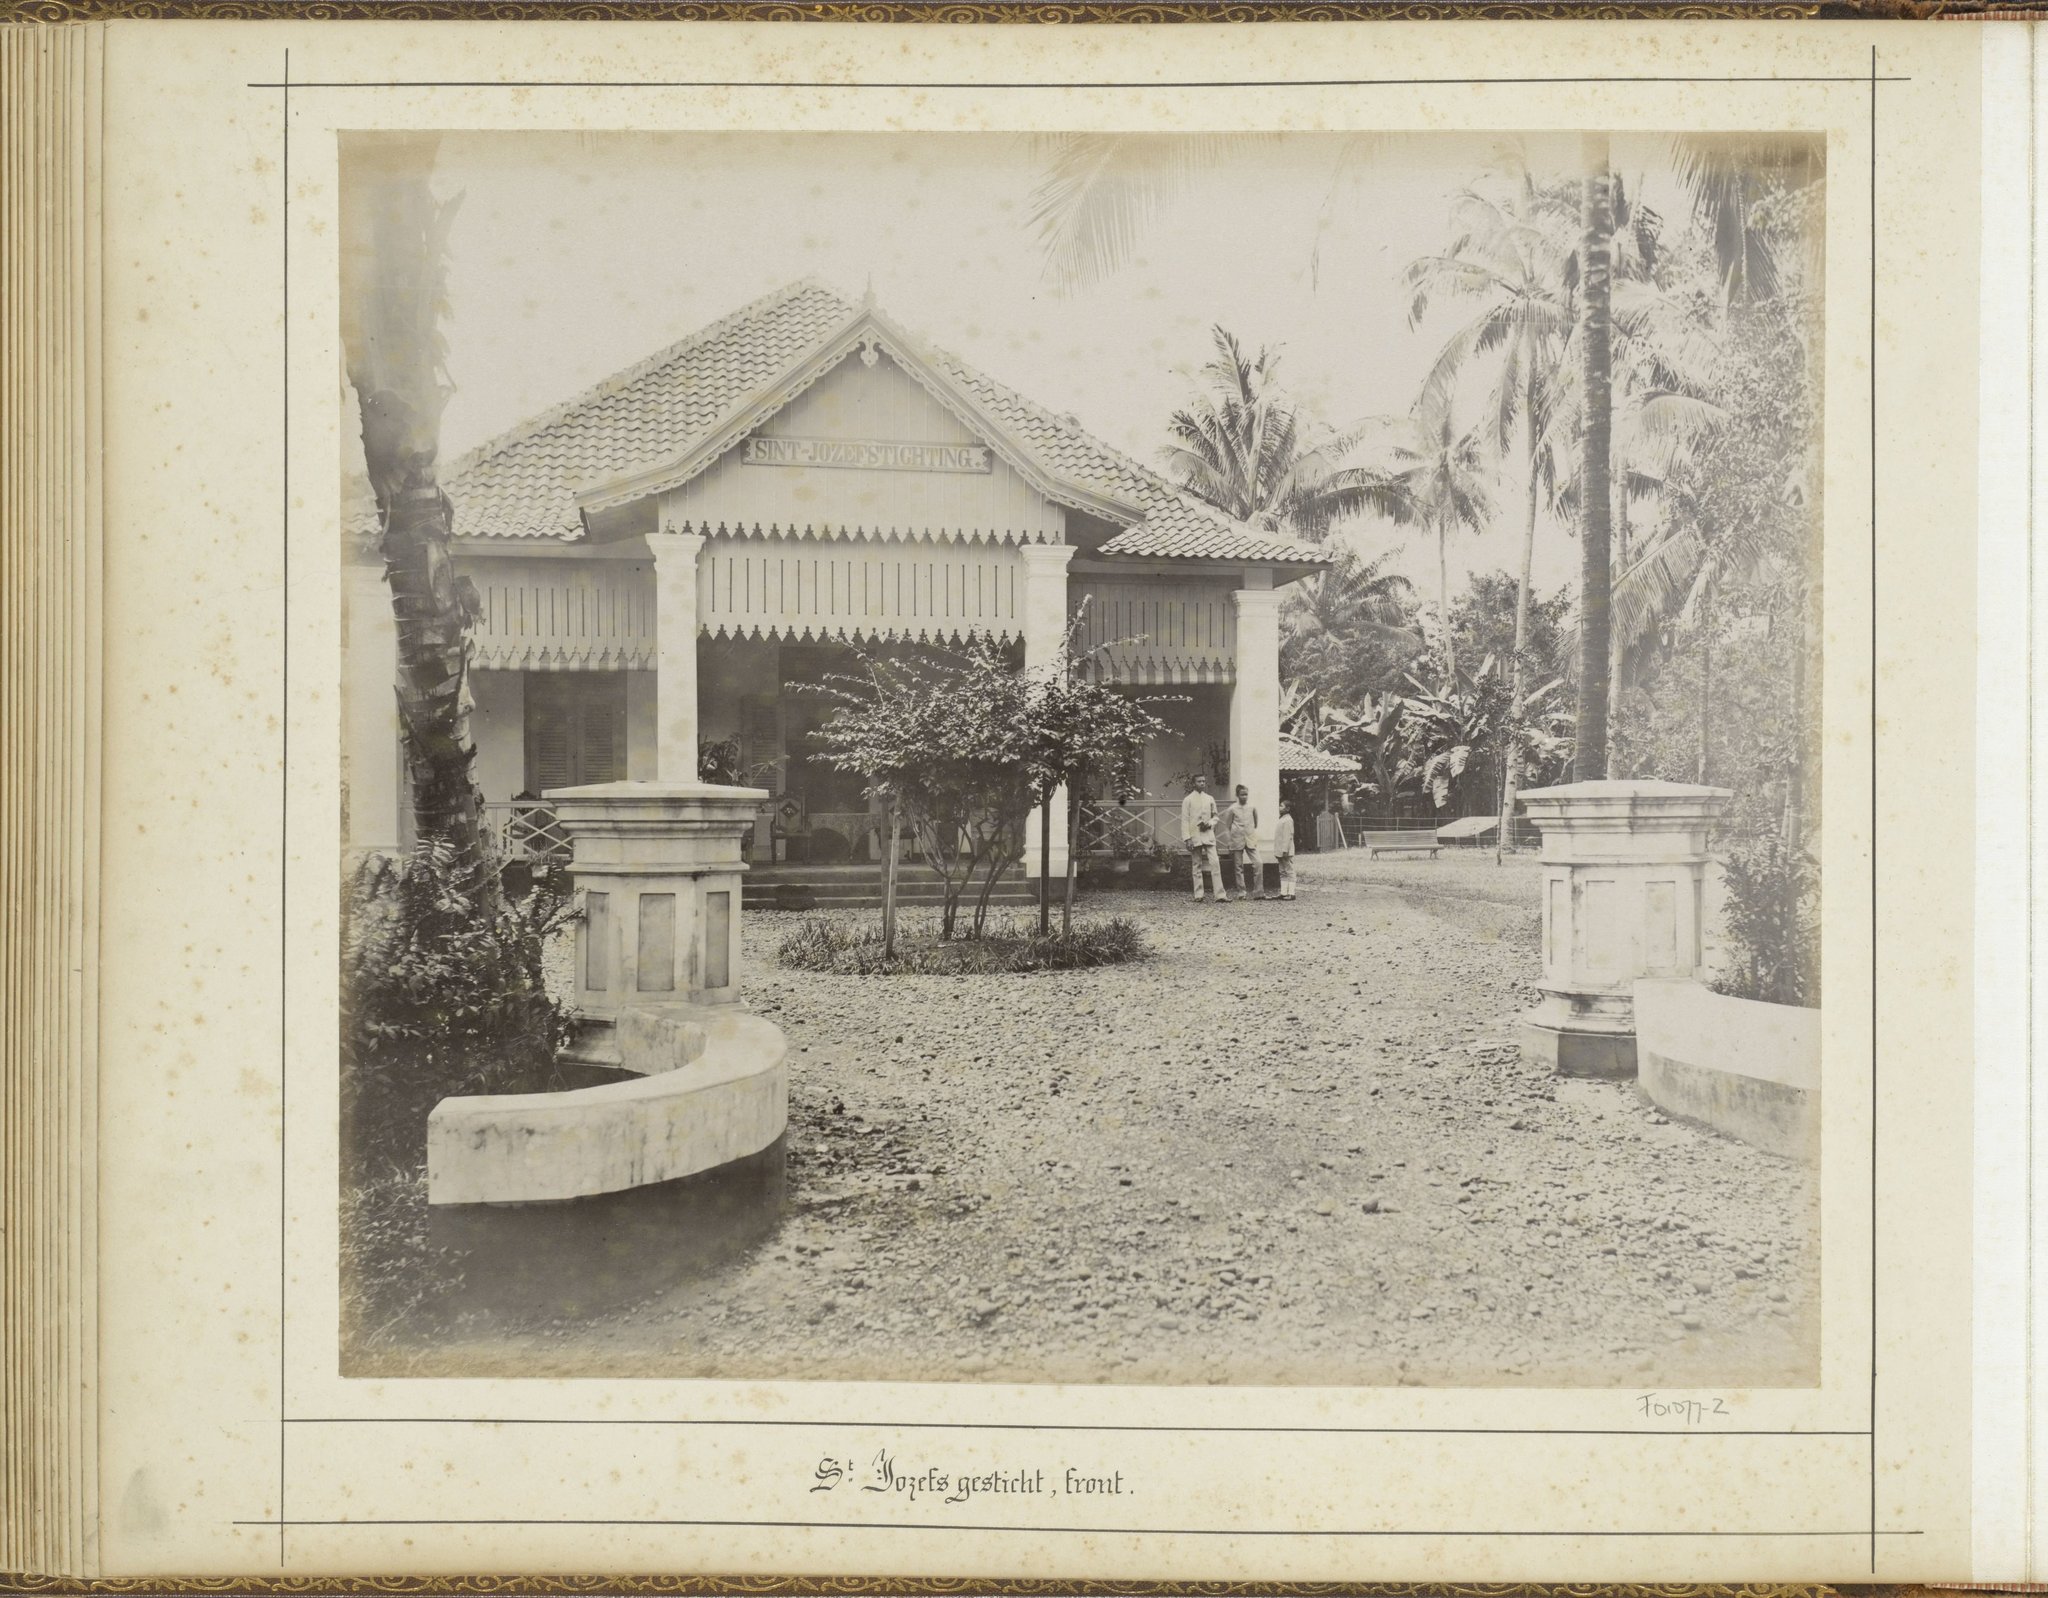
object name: album leaf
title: St. Jozefs gesticht, front.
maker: Anonymous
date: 1890-1910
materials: cardboard, photographic support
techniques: albumen print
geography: weltevreden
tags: orphanage (+ variant), garden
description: Onderdeel van Album met foto's van Batavia en van de zusters Ursulinen.